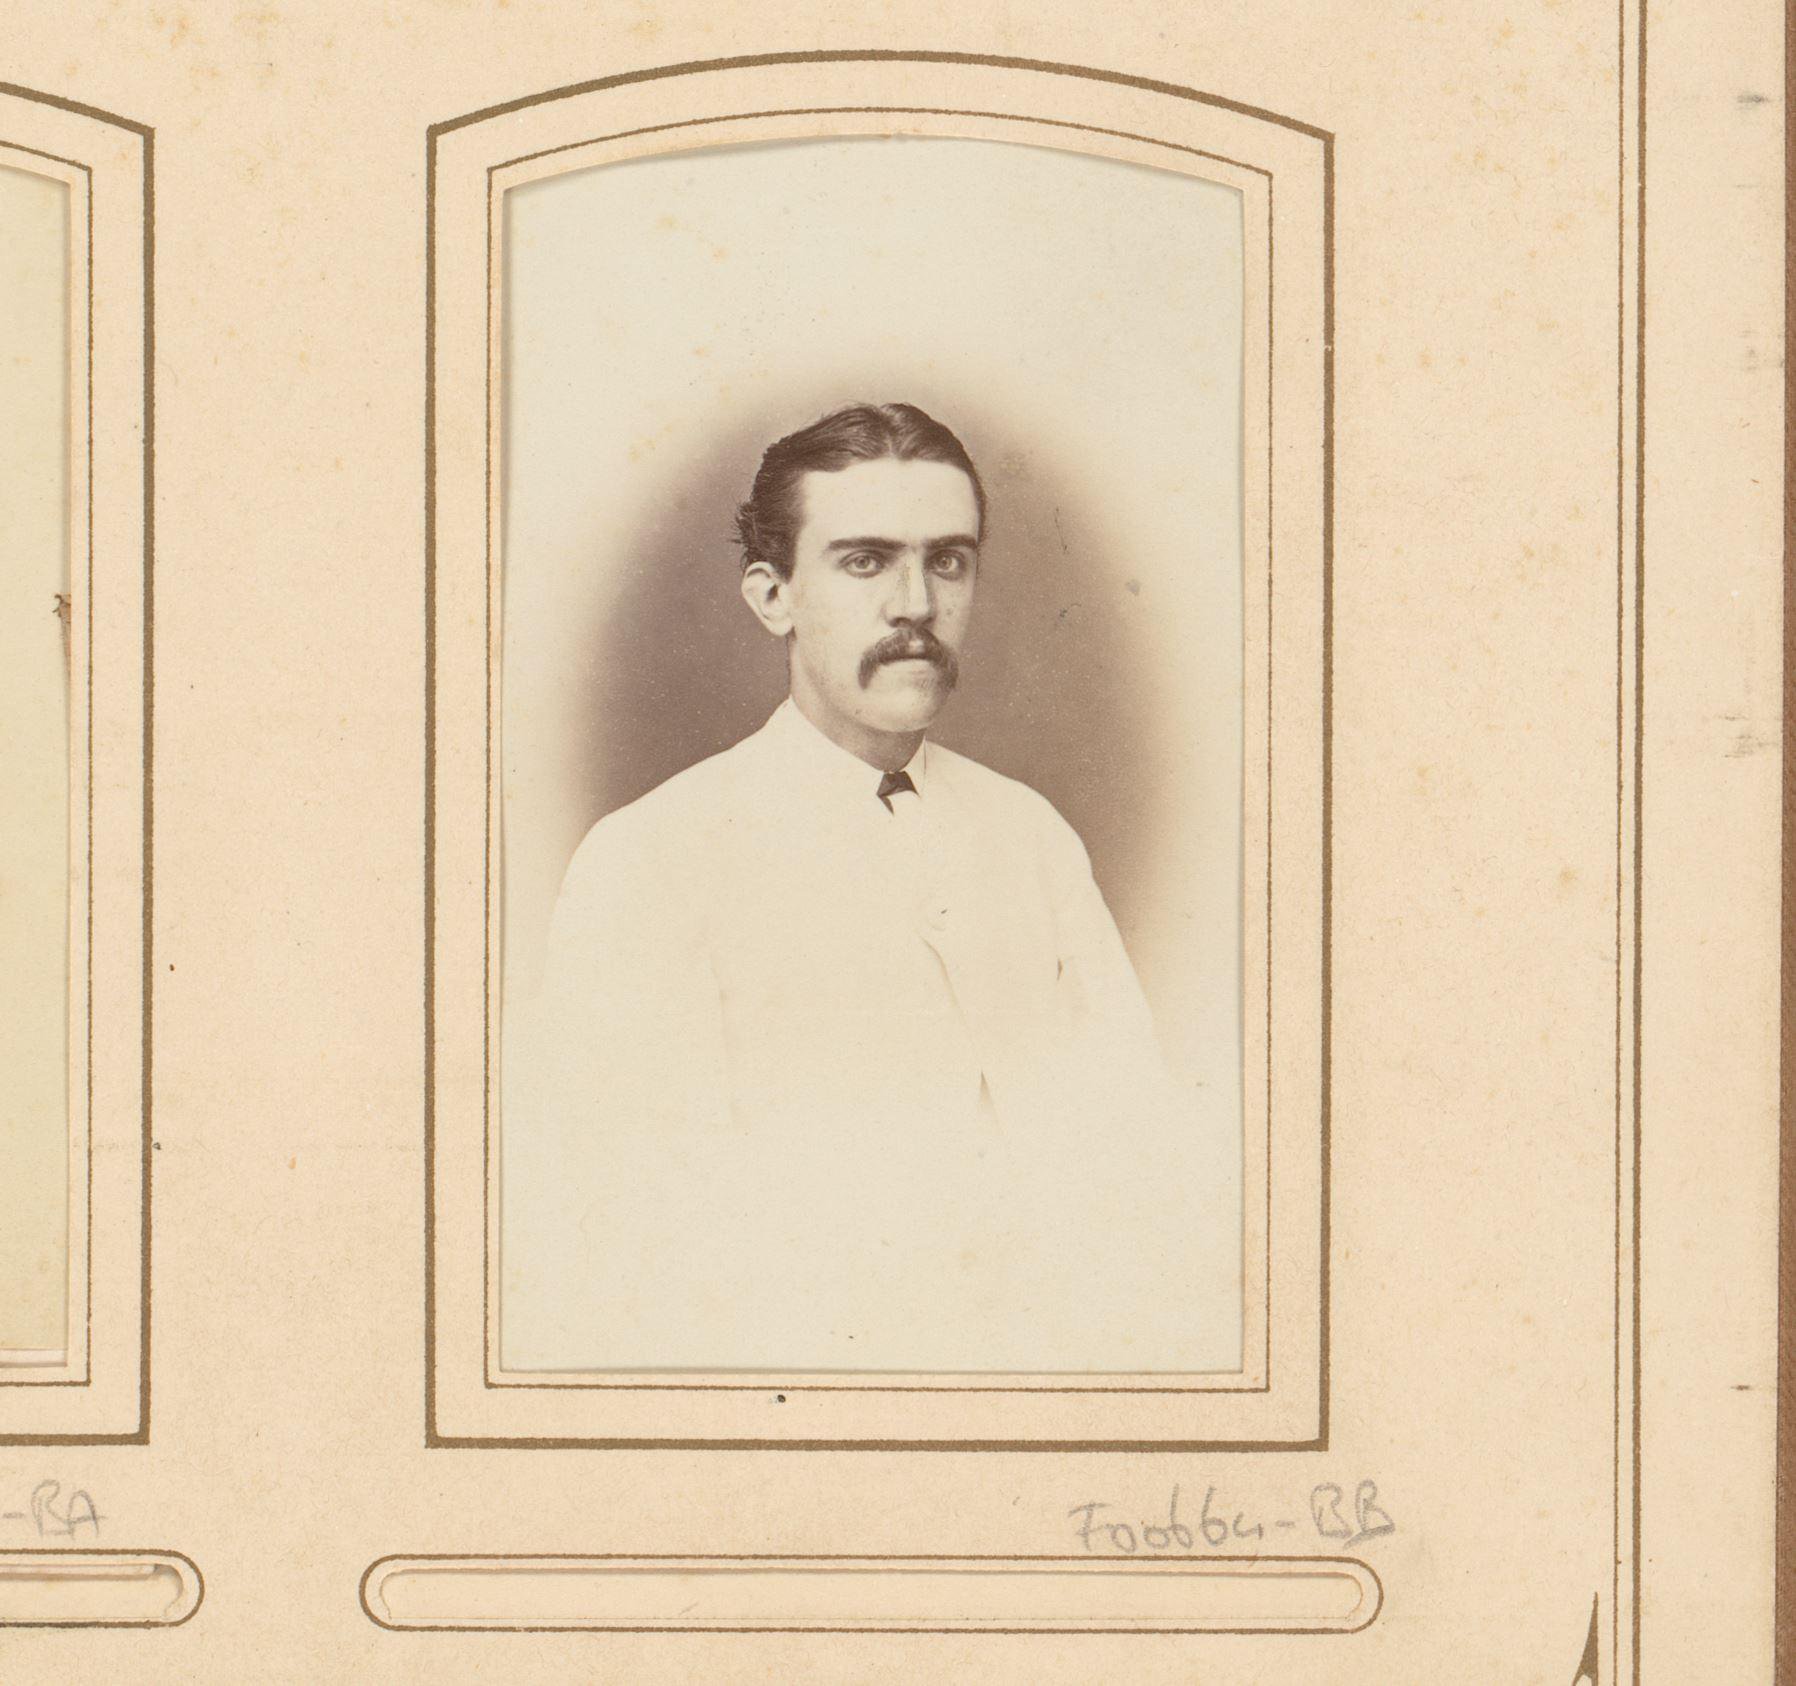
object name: album leaf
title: Portret van een man in wit pak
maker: j.b. jasper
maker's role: fotograaf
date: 1870-1899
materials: cardboard, photographic support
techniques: albumen print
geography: surabaya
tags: historical persons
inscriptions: inscription: ‘J.B. Jasper/ Photograaf/ Soerabaija’